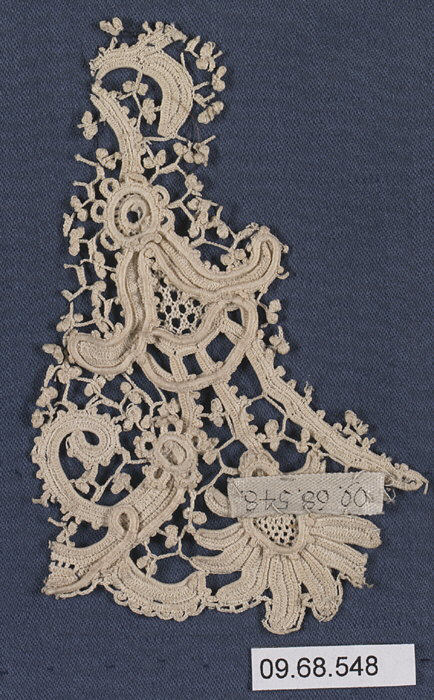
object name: specimen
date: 1801-1900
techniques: crochet